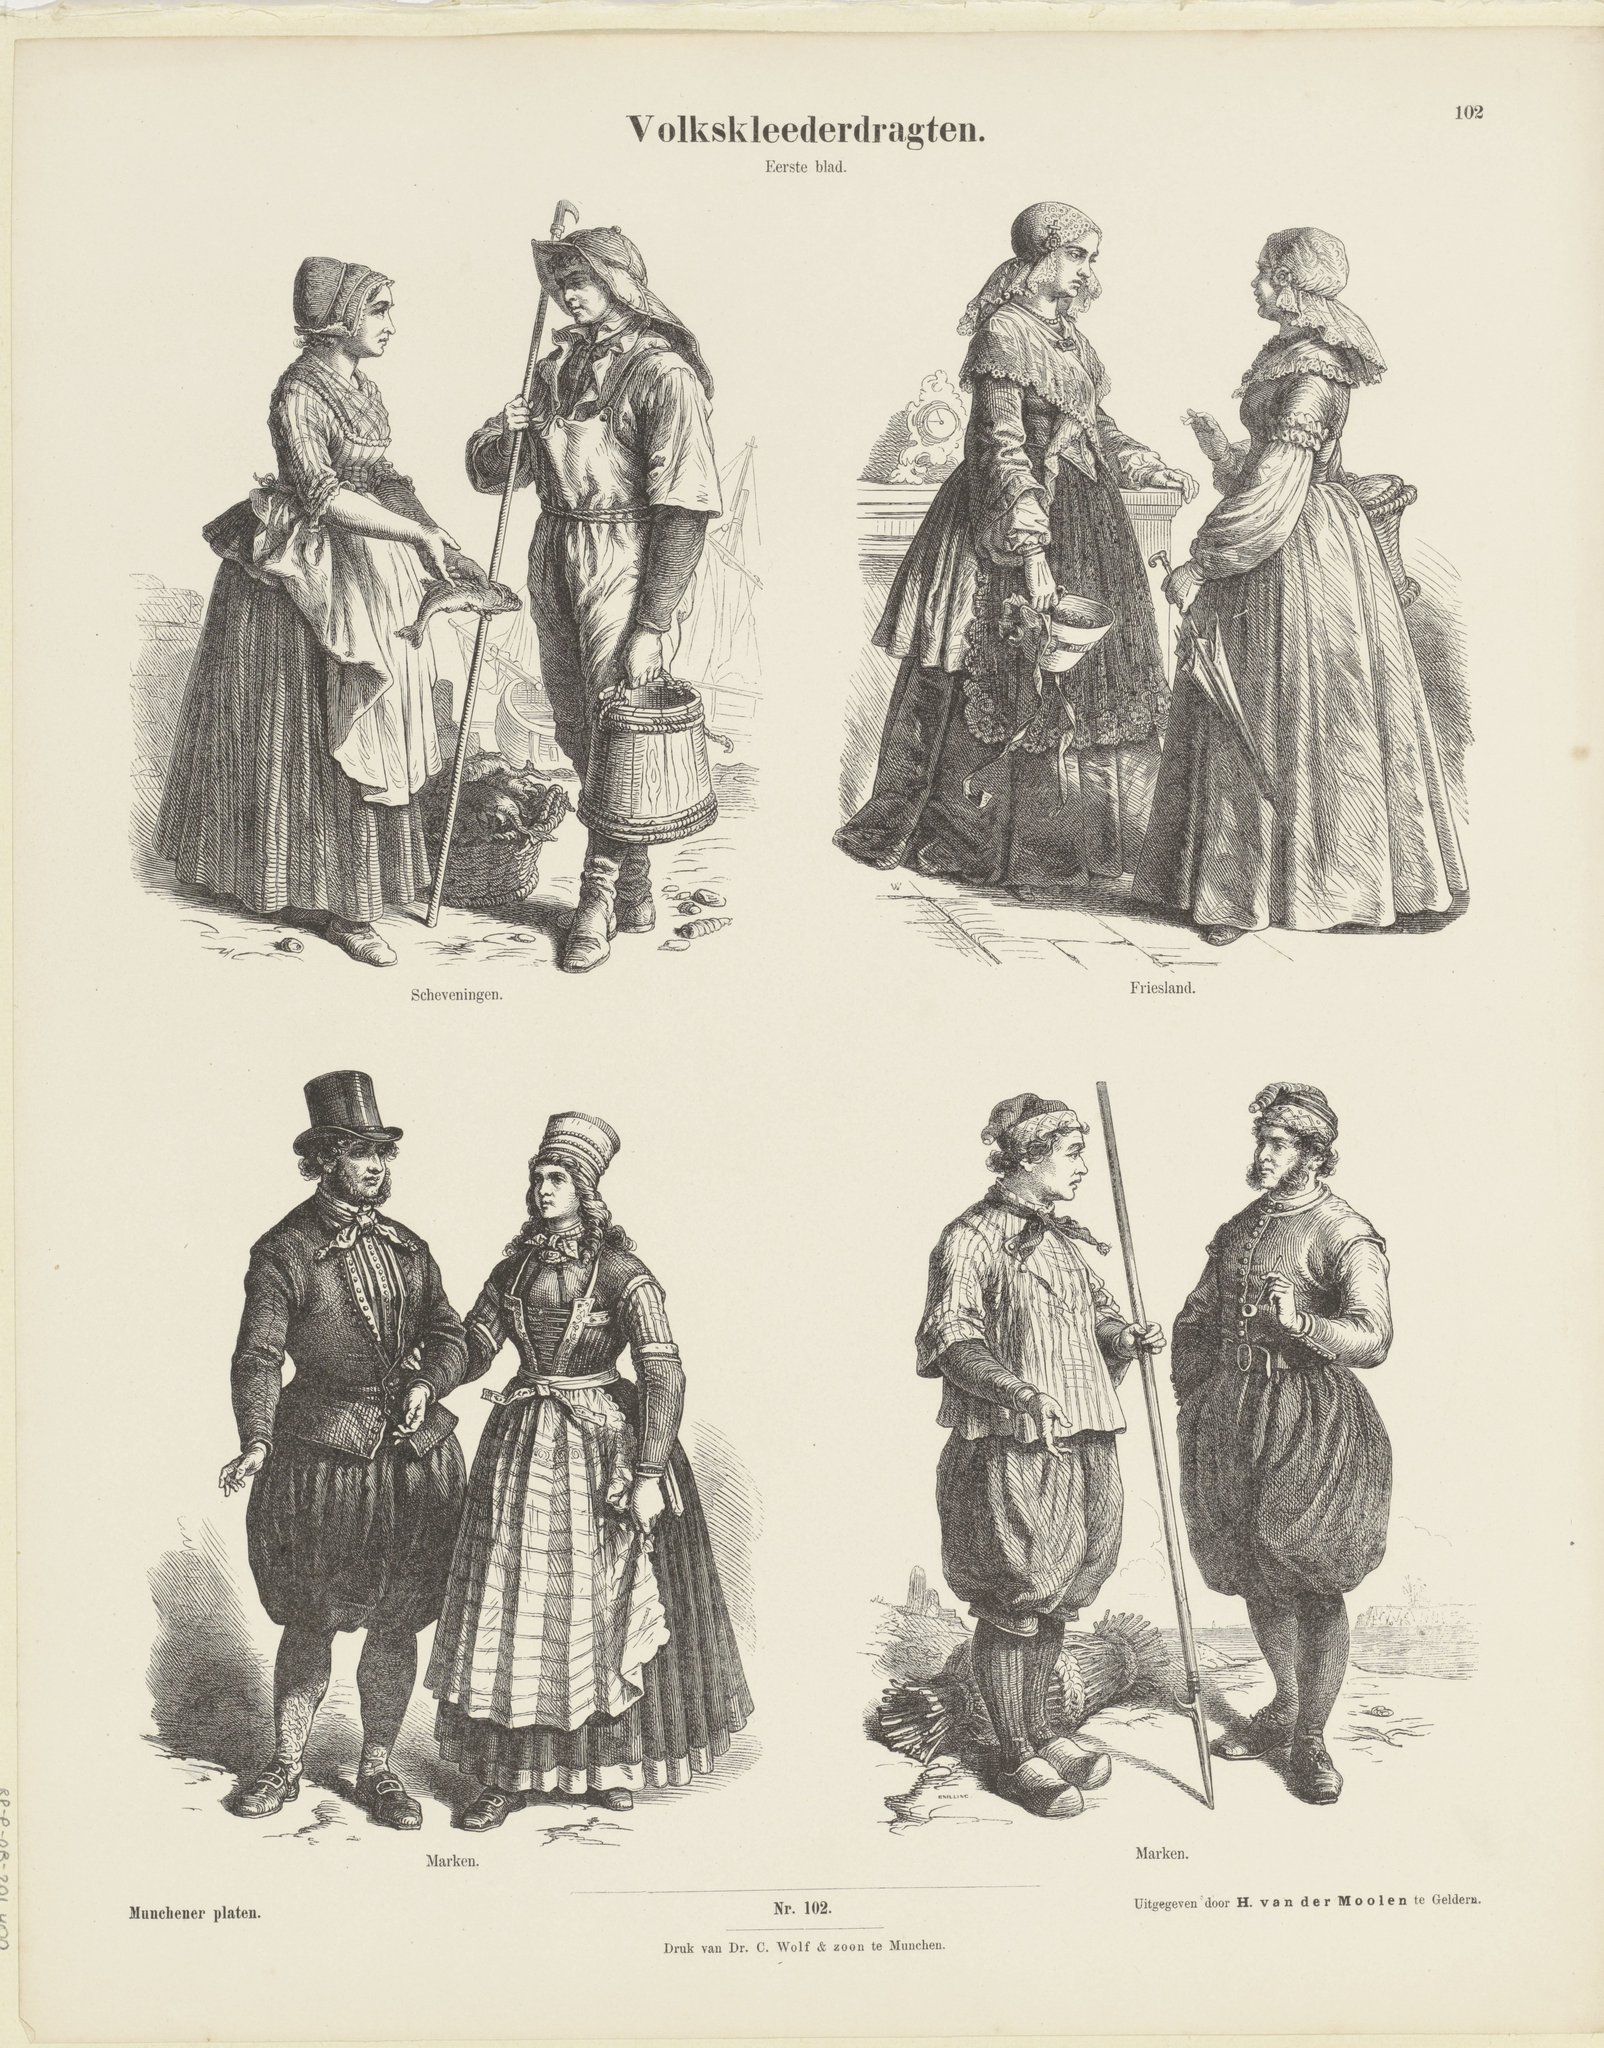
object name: popular print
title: Volkskleederdragten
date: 1843-1920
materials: paper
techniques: letterpress printing, engraving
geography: munich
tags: historical costume, folk costume, regional costume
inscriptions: collector's mark: Lugt 2760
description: Blad met 4 voorstellingen van mensen in verschillende historische Nederlandse klederdrachten, waaronder een paar uit Scheveningen, twee vrouwen uit Friesland en een paar en twee mannen uit Marken. Onder elke afbeelding een onderschrift. Genummerd midden onder: Nro. 102. Genummerd rechtsboven: 102.